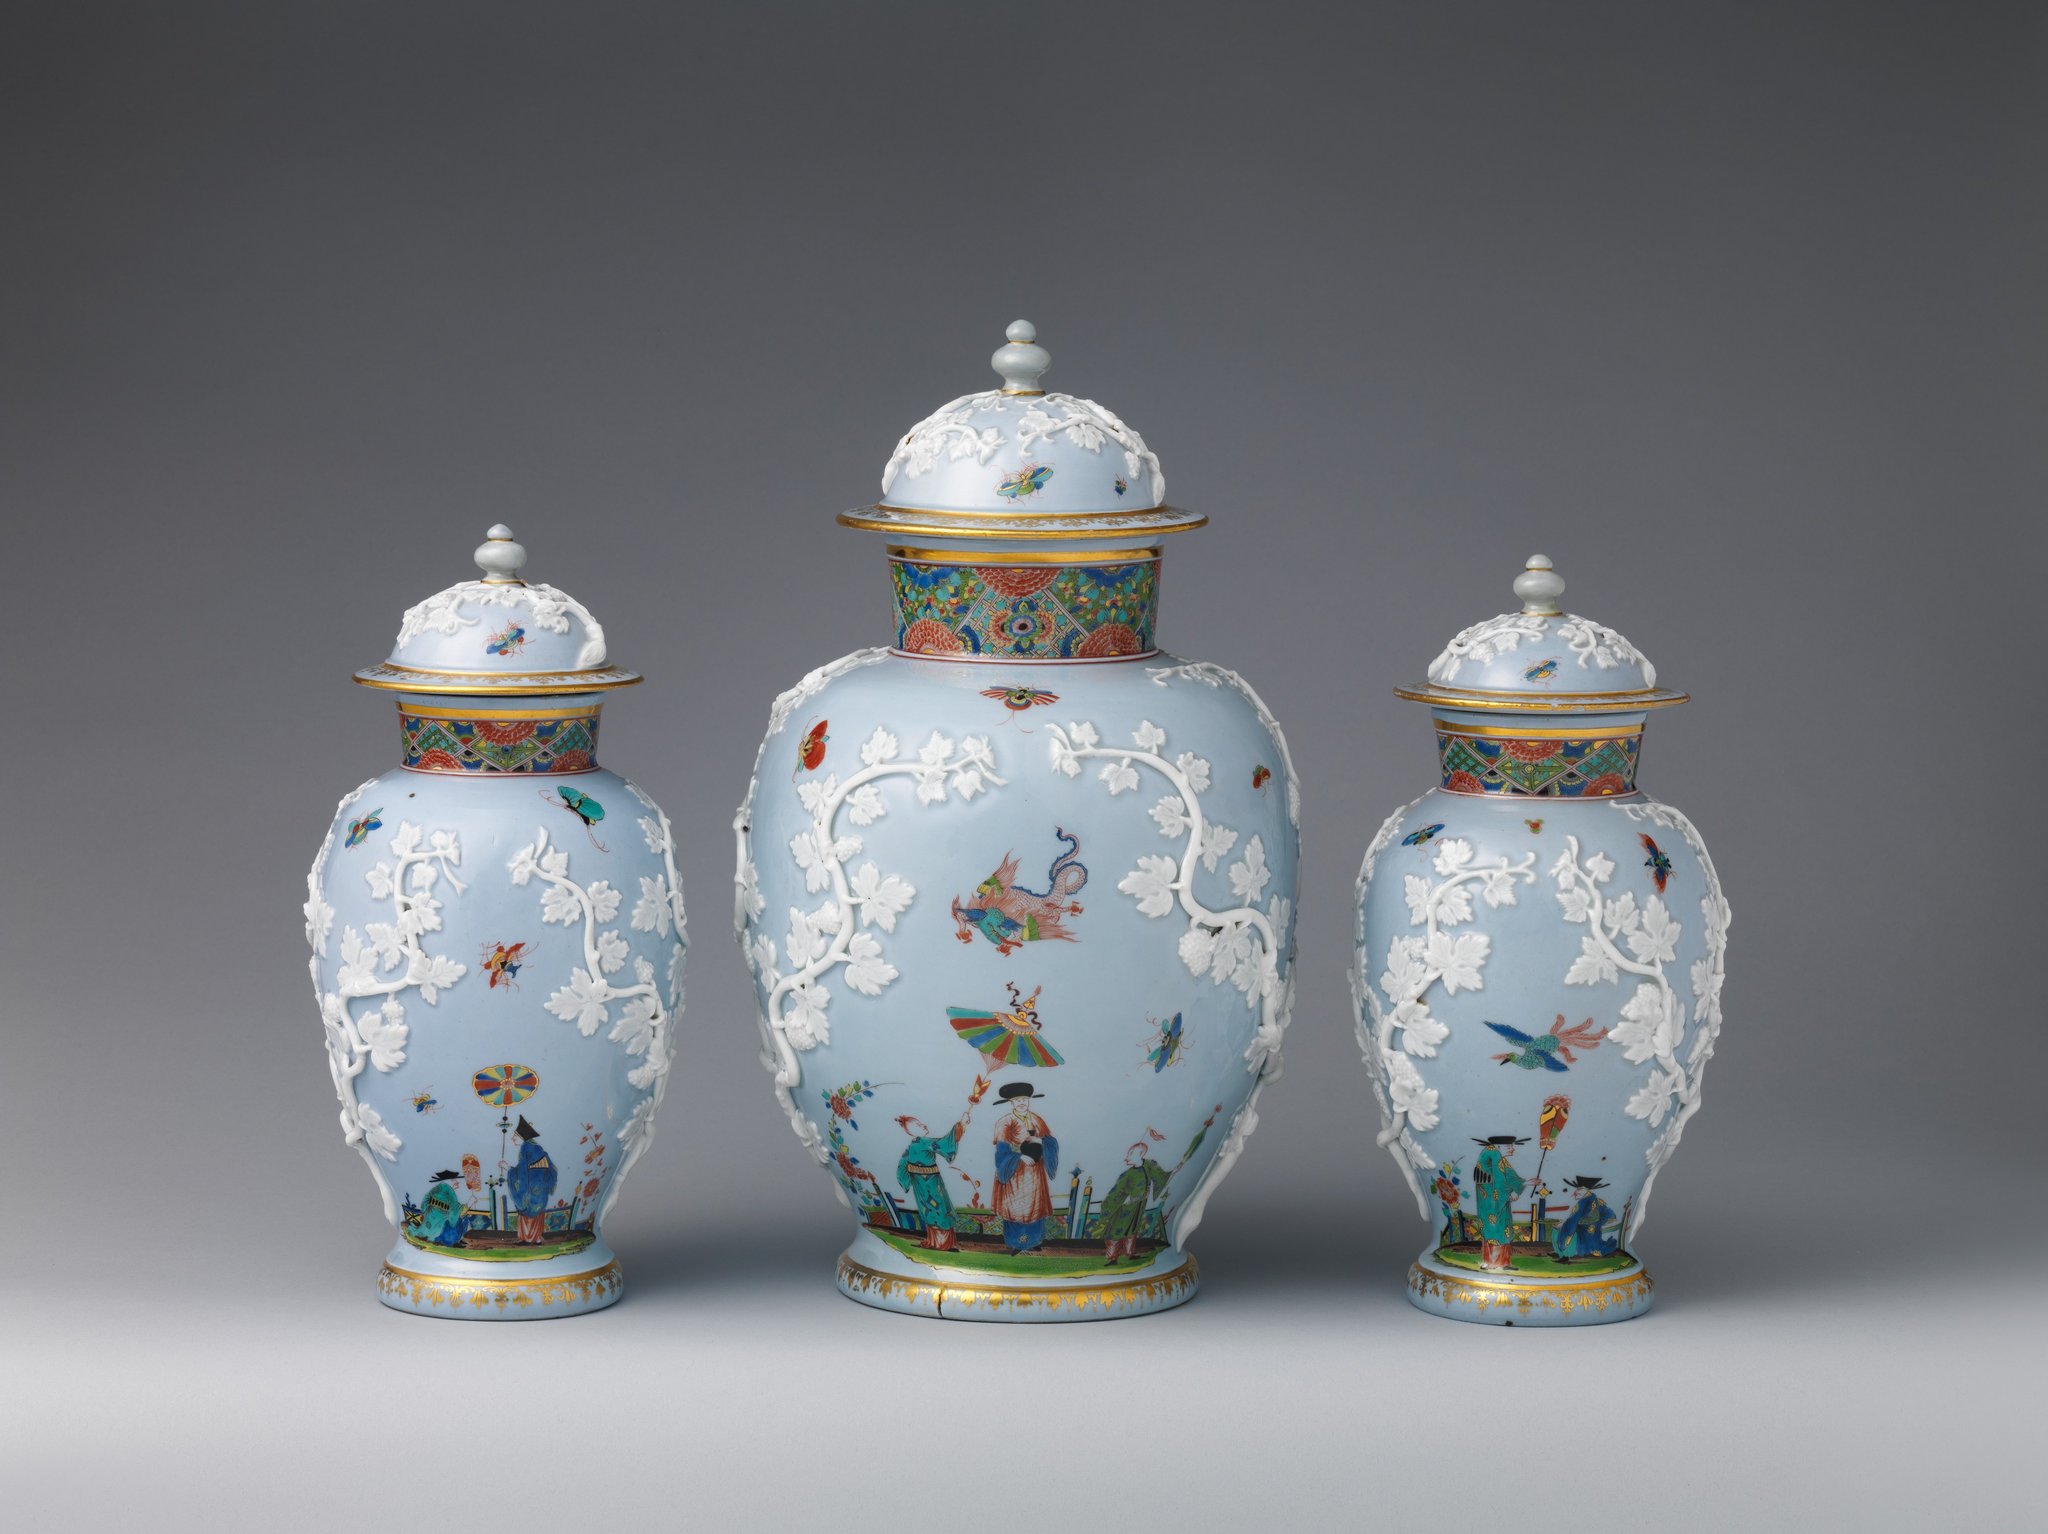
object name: vase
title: Vase (from a garniture of three)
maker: meissen manufactory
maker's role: manufactory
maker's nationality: german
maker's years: 1710-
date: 1725-1730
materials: enamel, gold, hard paste porcelain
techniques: polychrome, tinting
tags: chinoiserie,men,butterflies